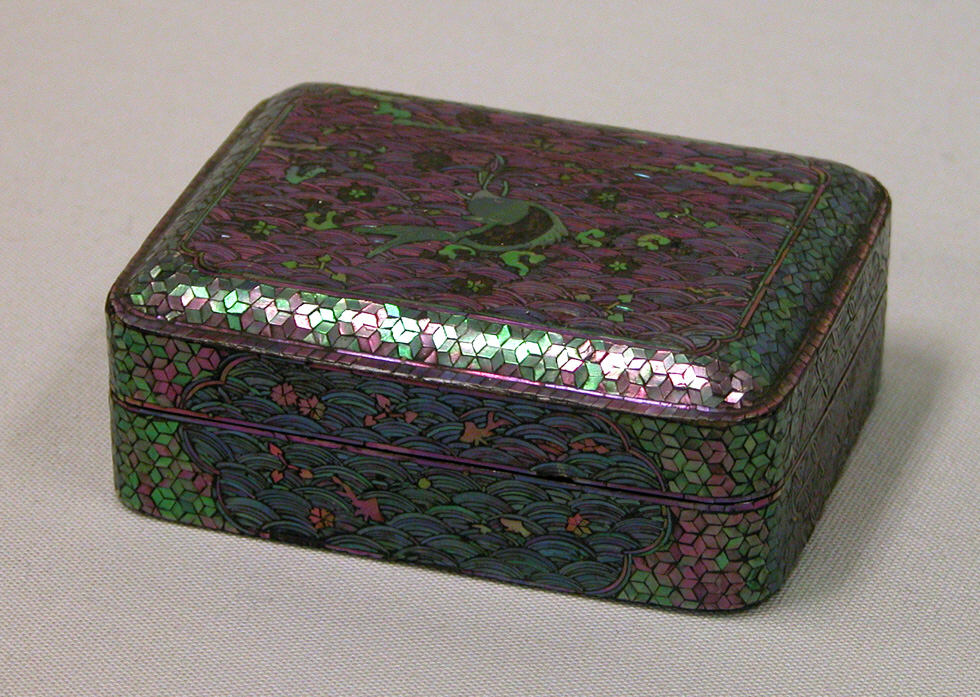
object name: box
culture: japanese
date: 1801-1900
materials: lacquer, mother of pearl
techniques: inlay